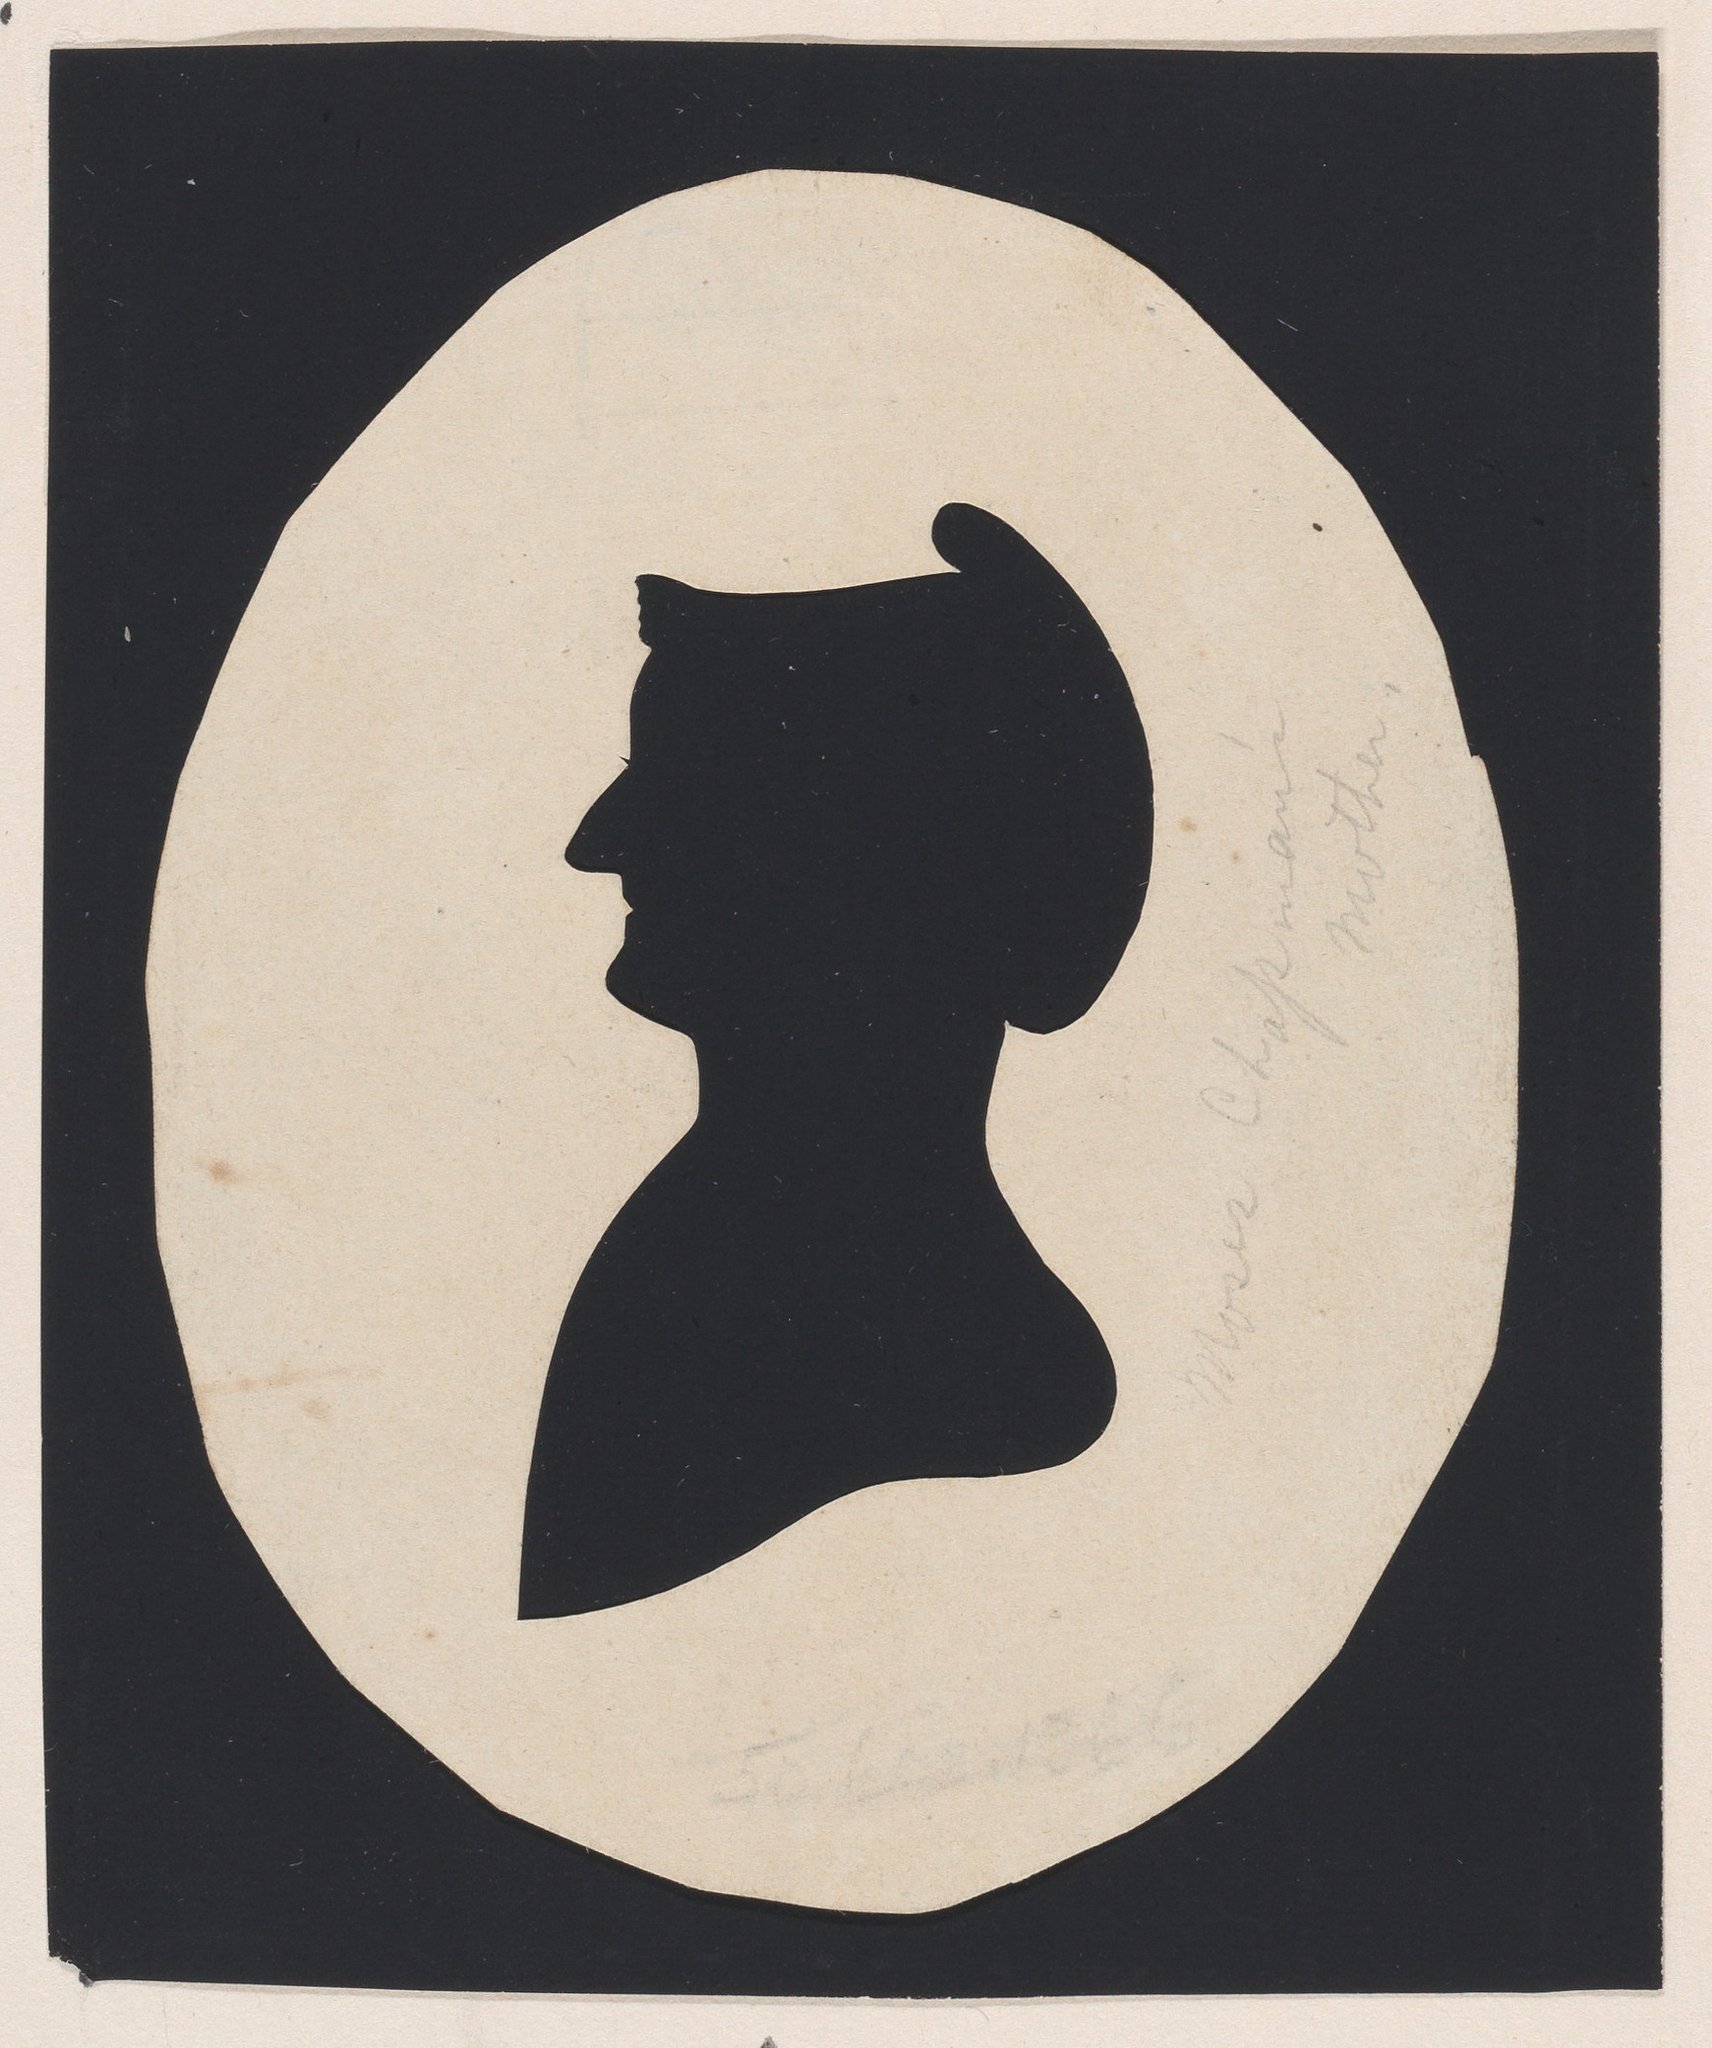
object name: cut paper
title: Silhouette of Mrs. Chapman, mother of the artist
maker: moses chapman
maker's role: artist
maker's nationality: american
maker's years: 1783-1821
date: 1803-1821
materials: paper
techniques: cutting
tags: women